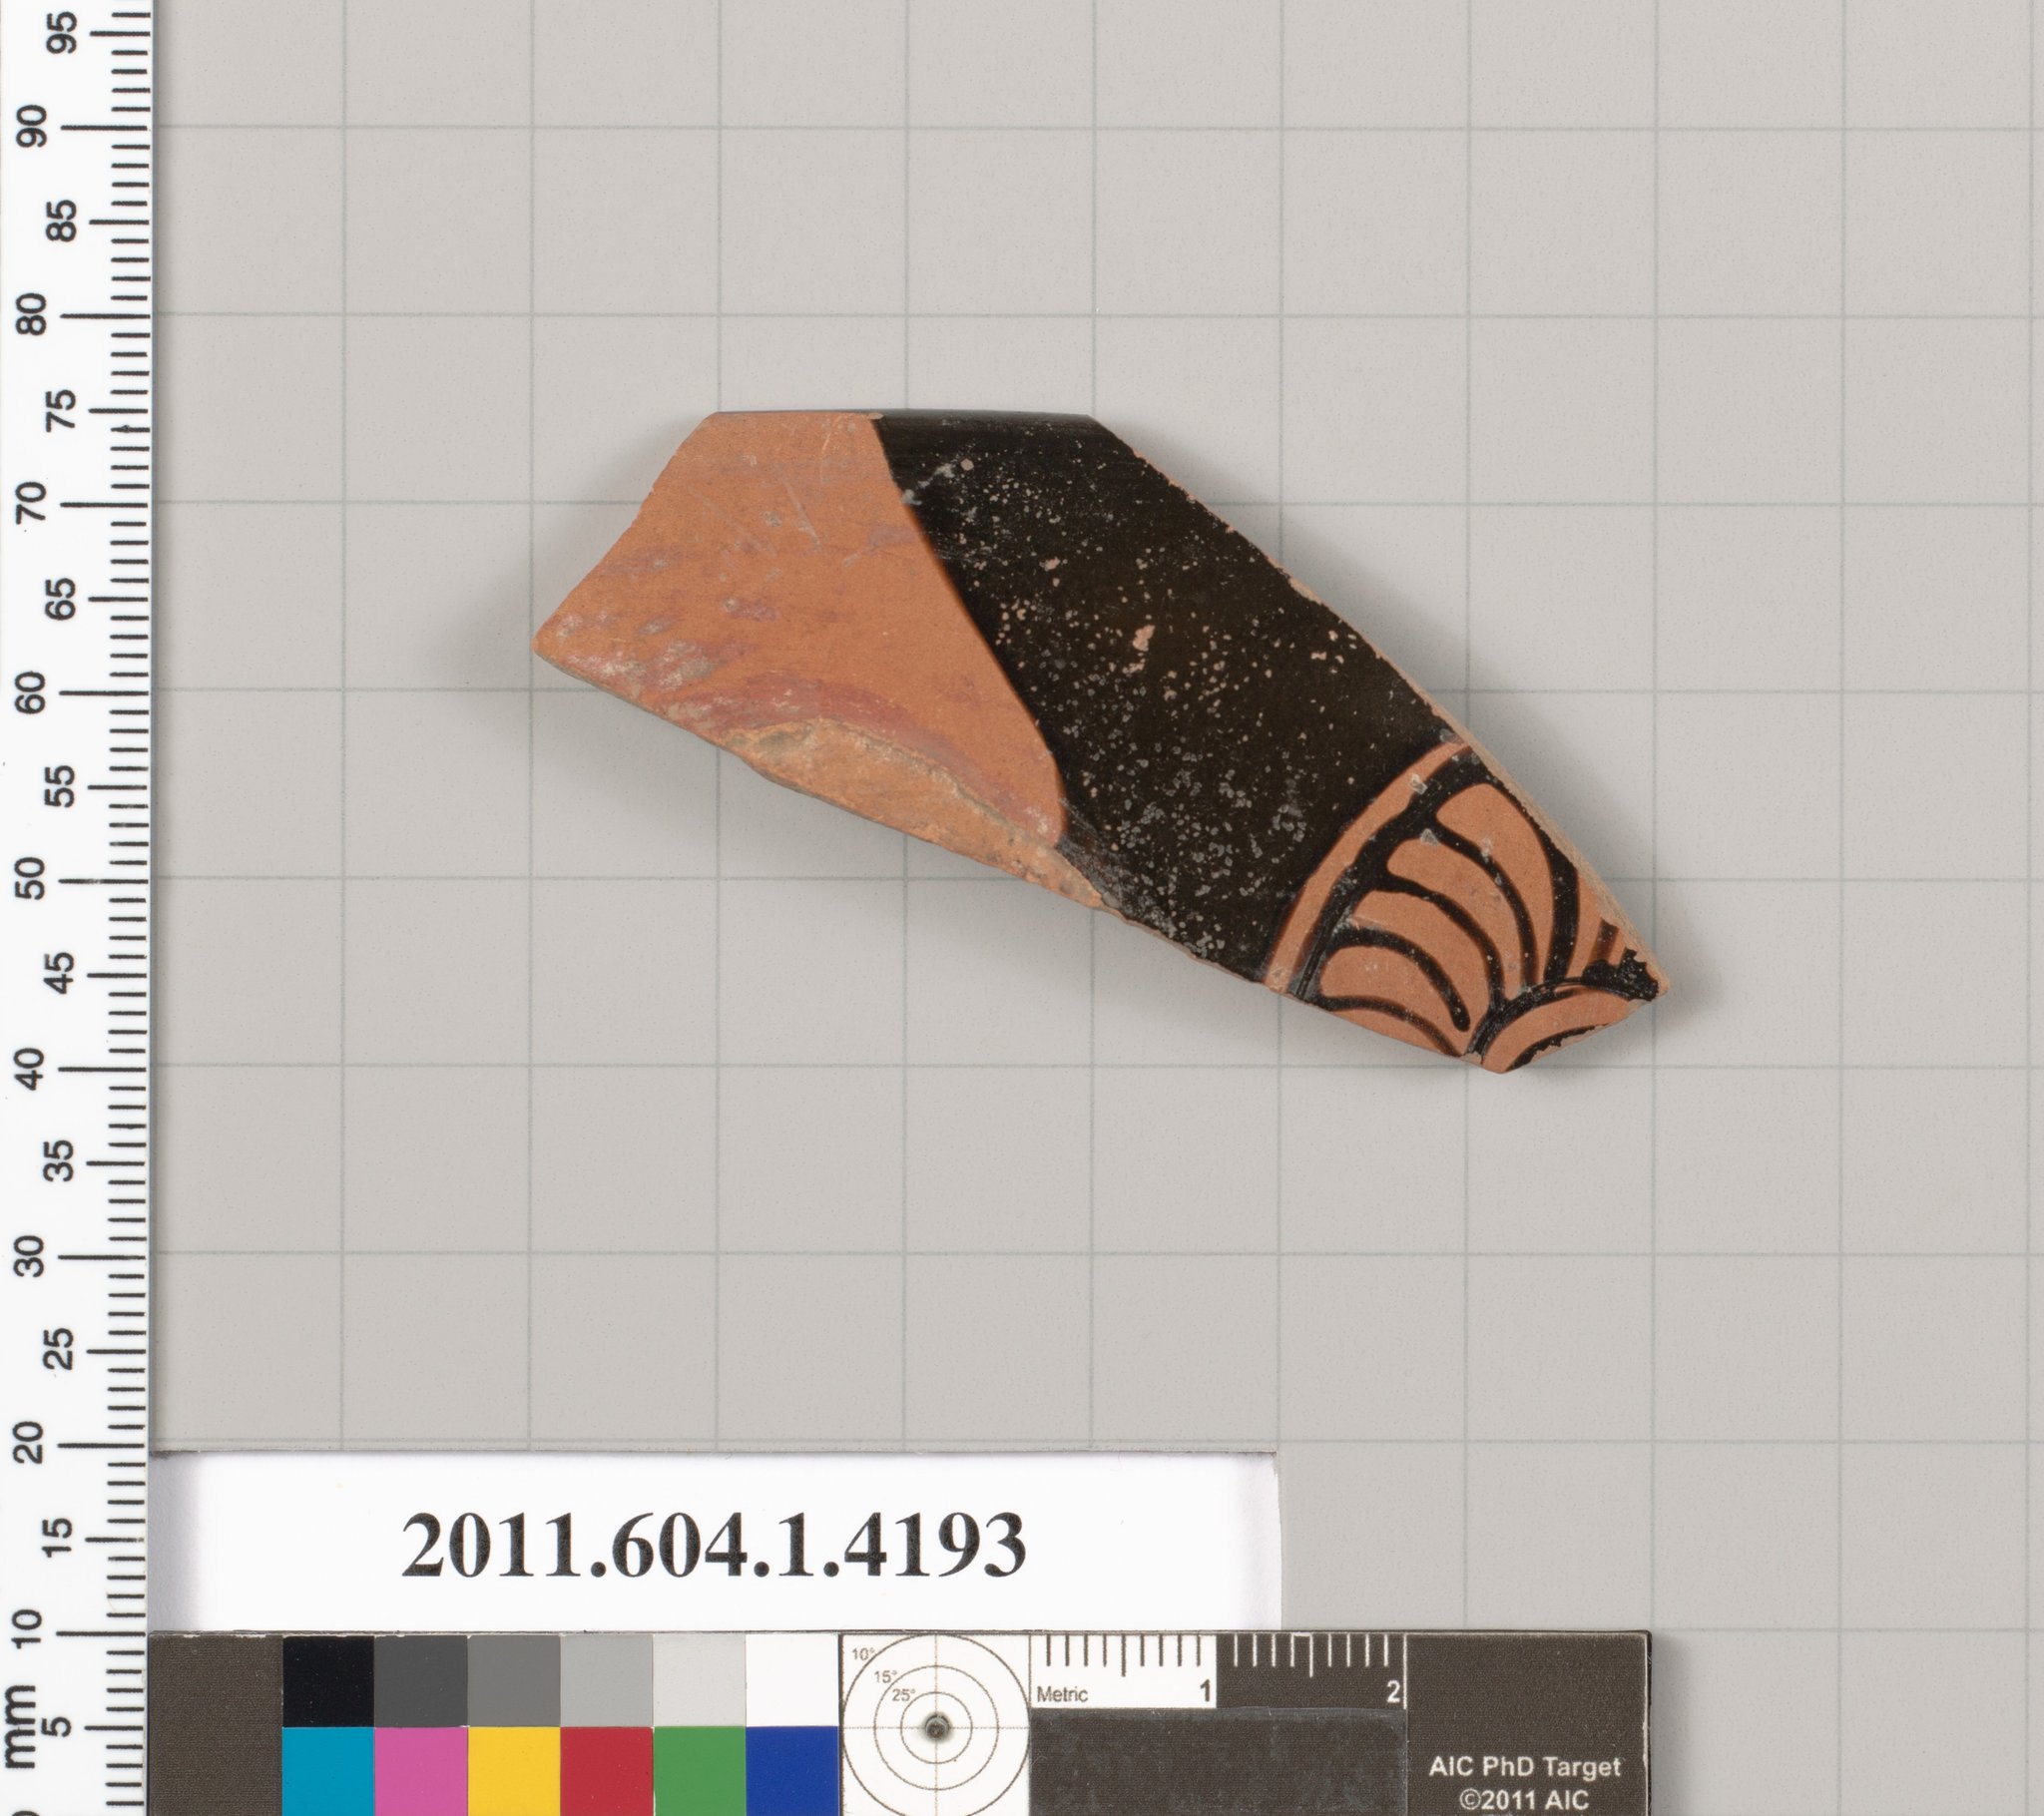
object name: kylix fragment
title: Terracotta rim fragment of a kylix (drinking cup)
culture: greek, attic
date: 475-451 BCE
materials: terracotta